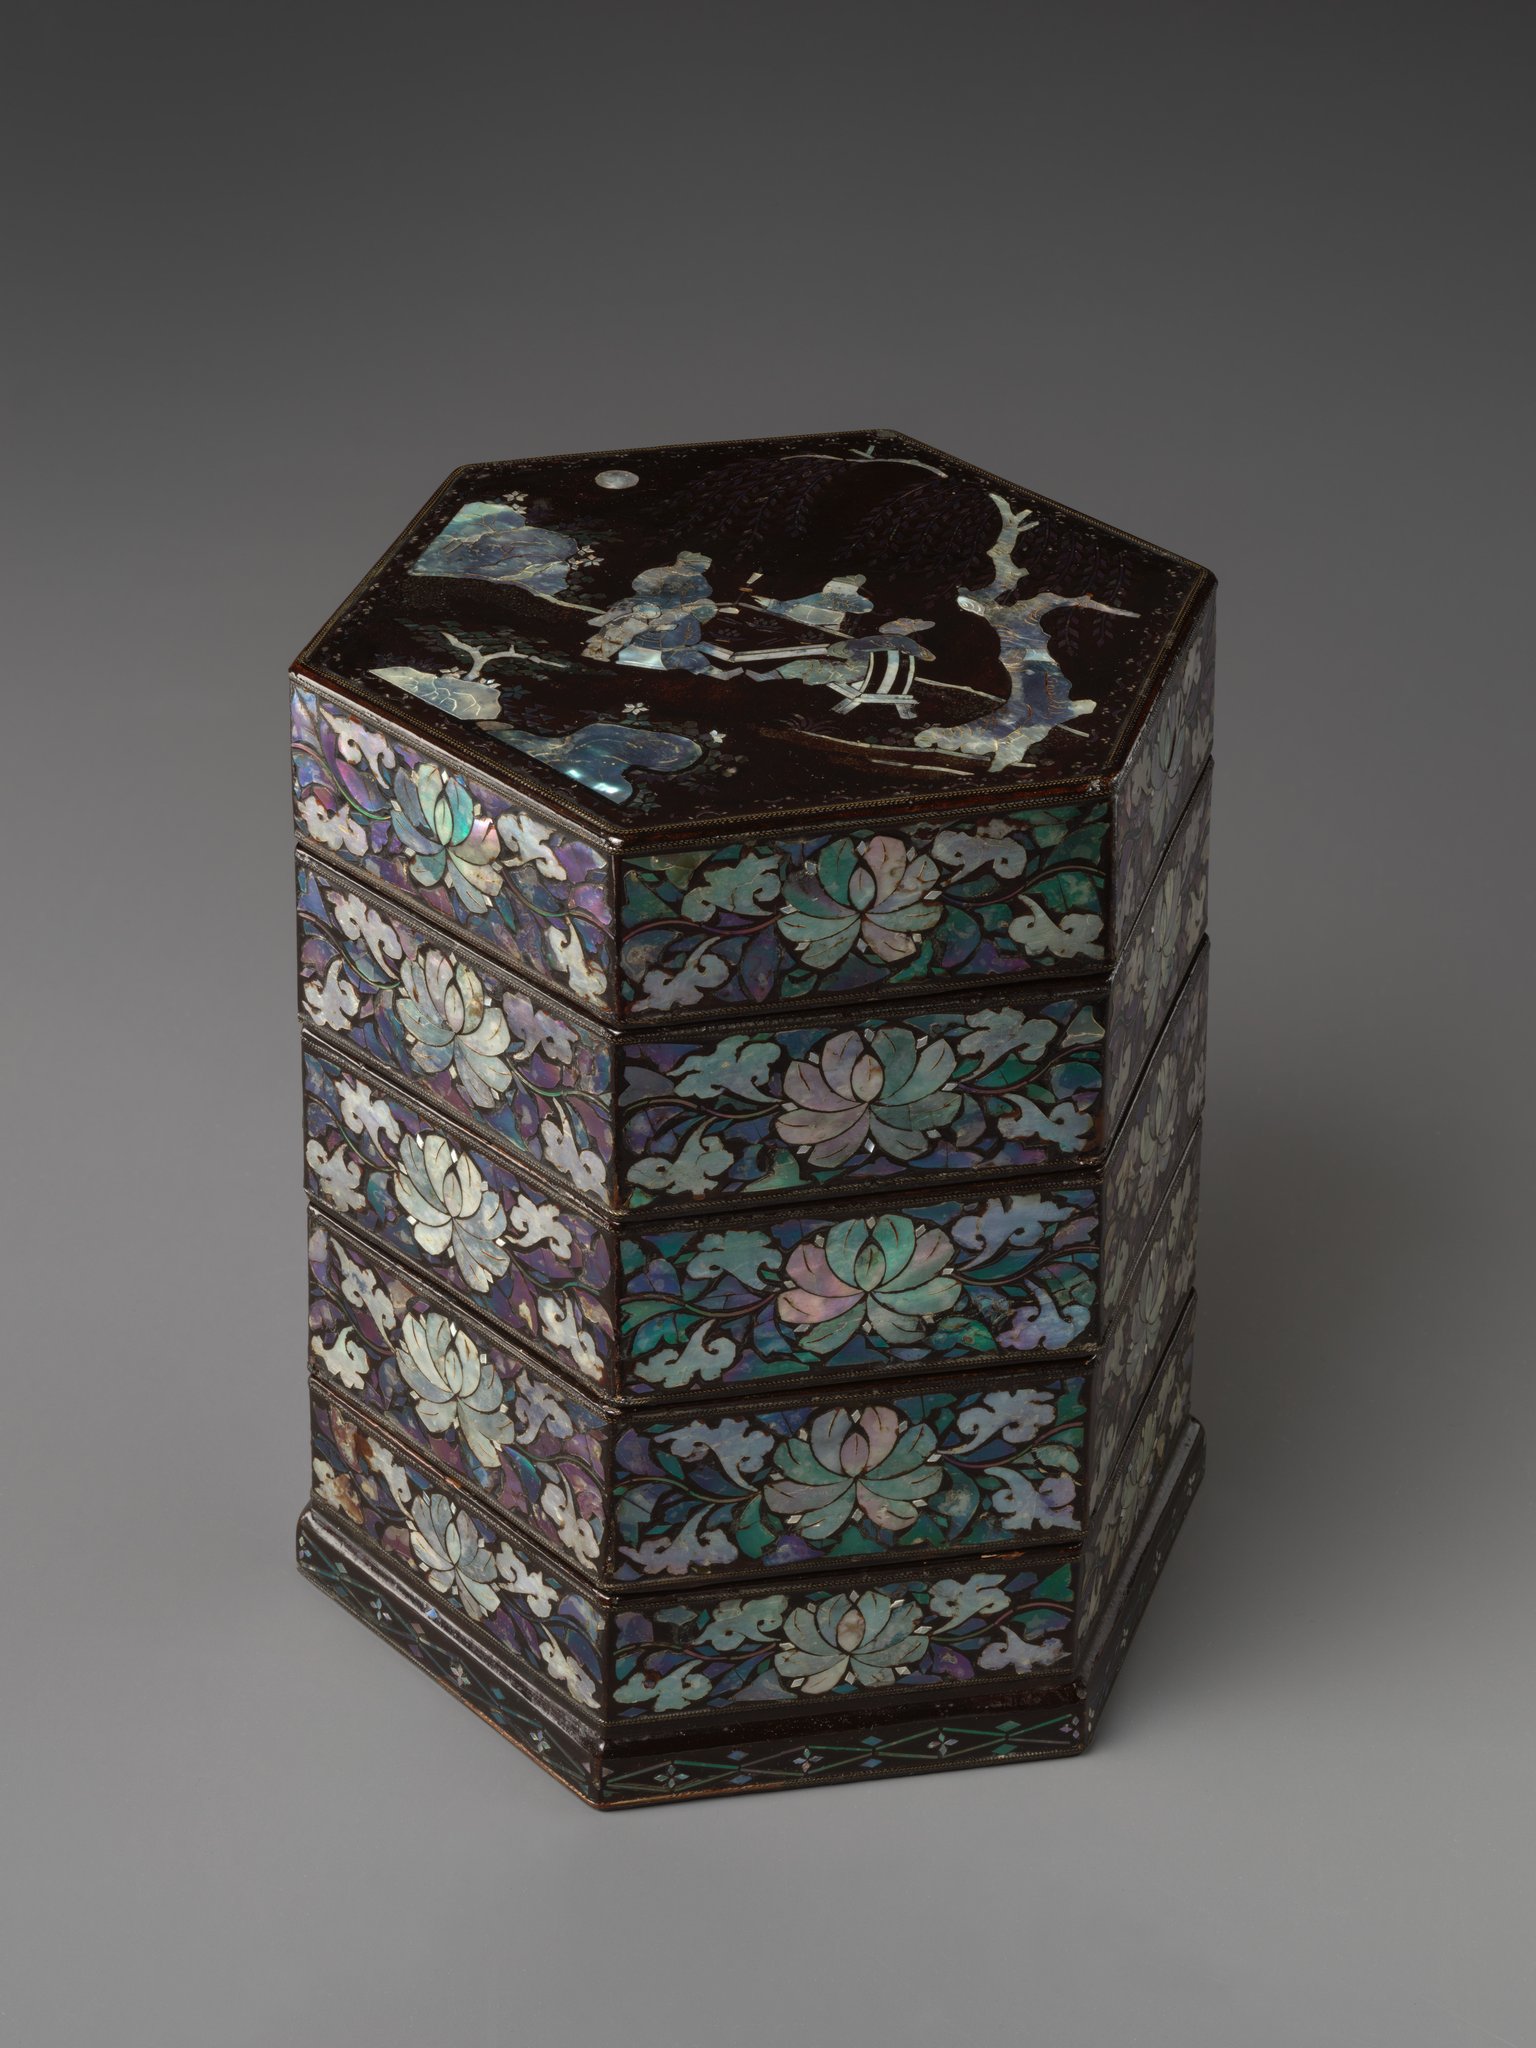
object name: five box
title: Set of hexagonal stacked boxes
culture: japanese or ryukyuan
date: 1701-1800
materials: lacquer, mother of pearl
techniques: inlay